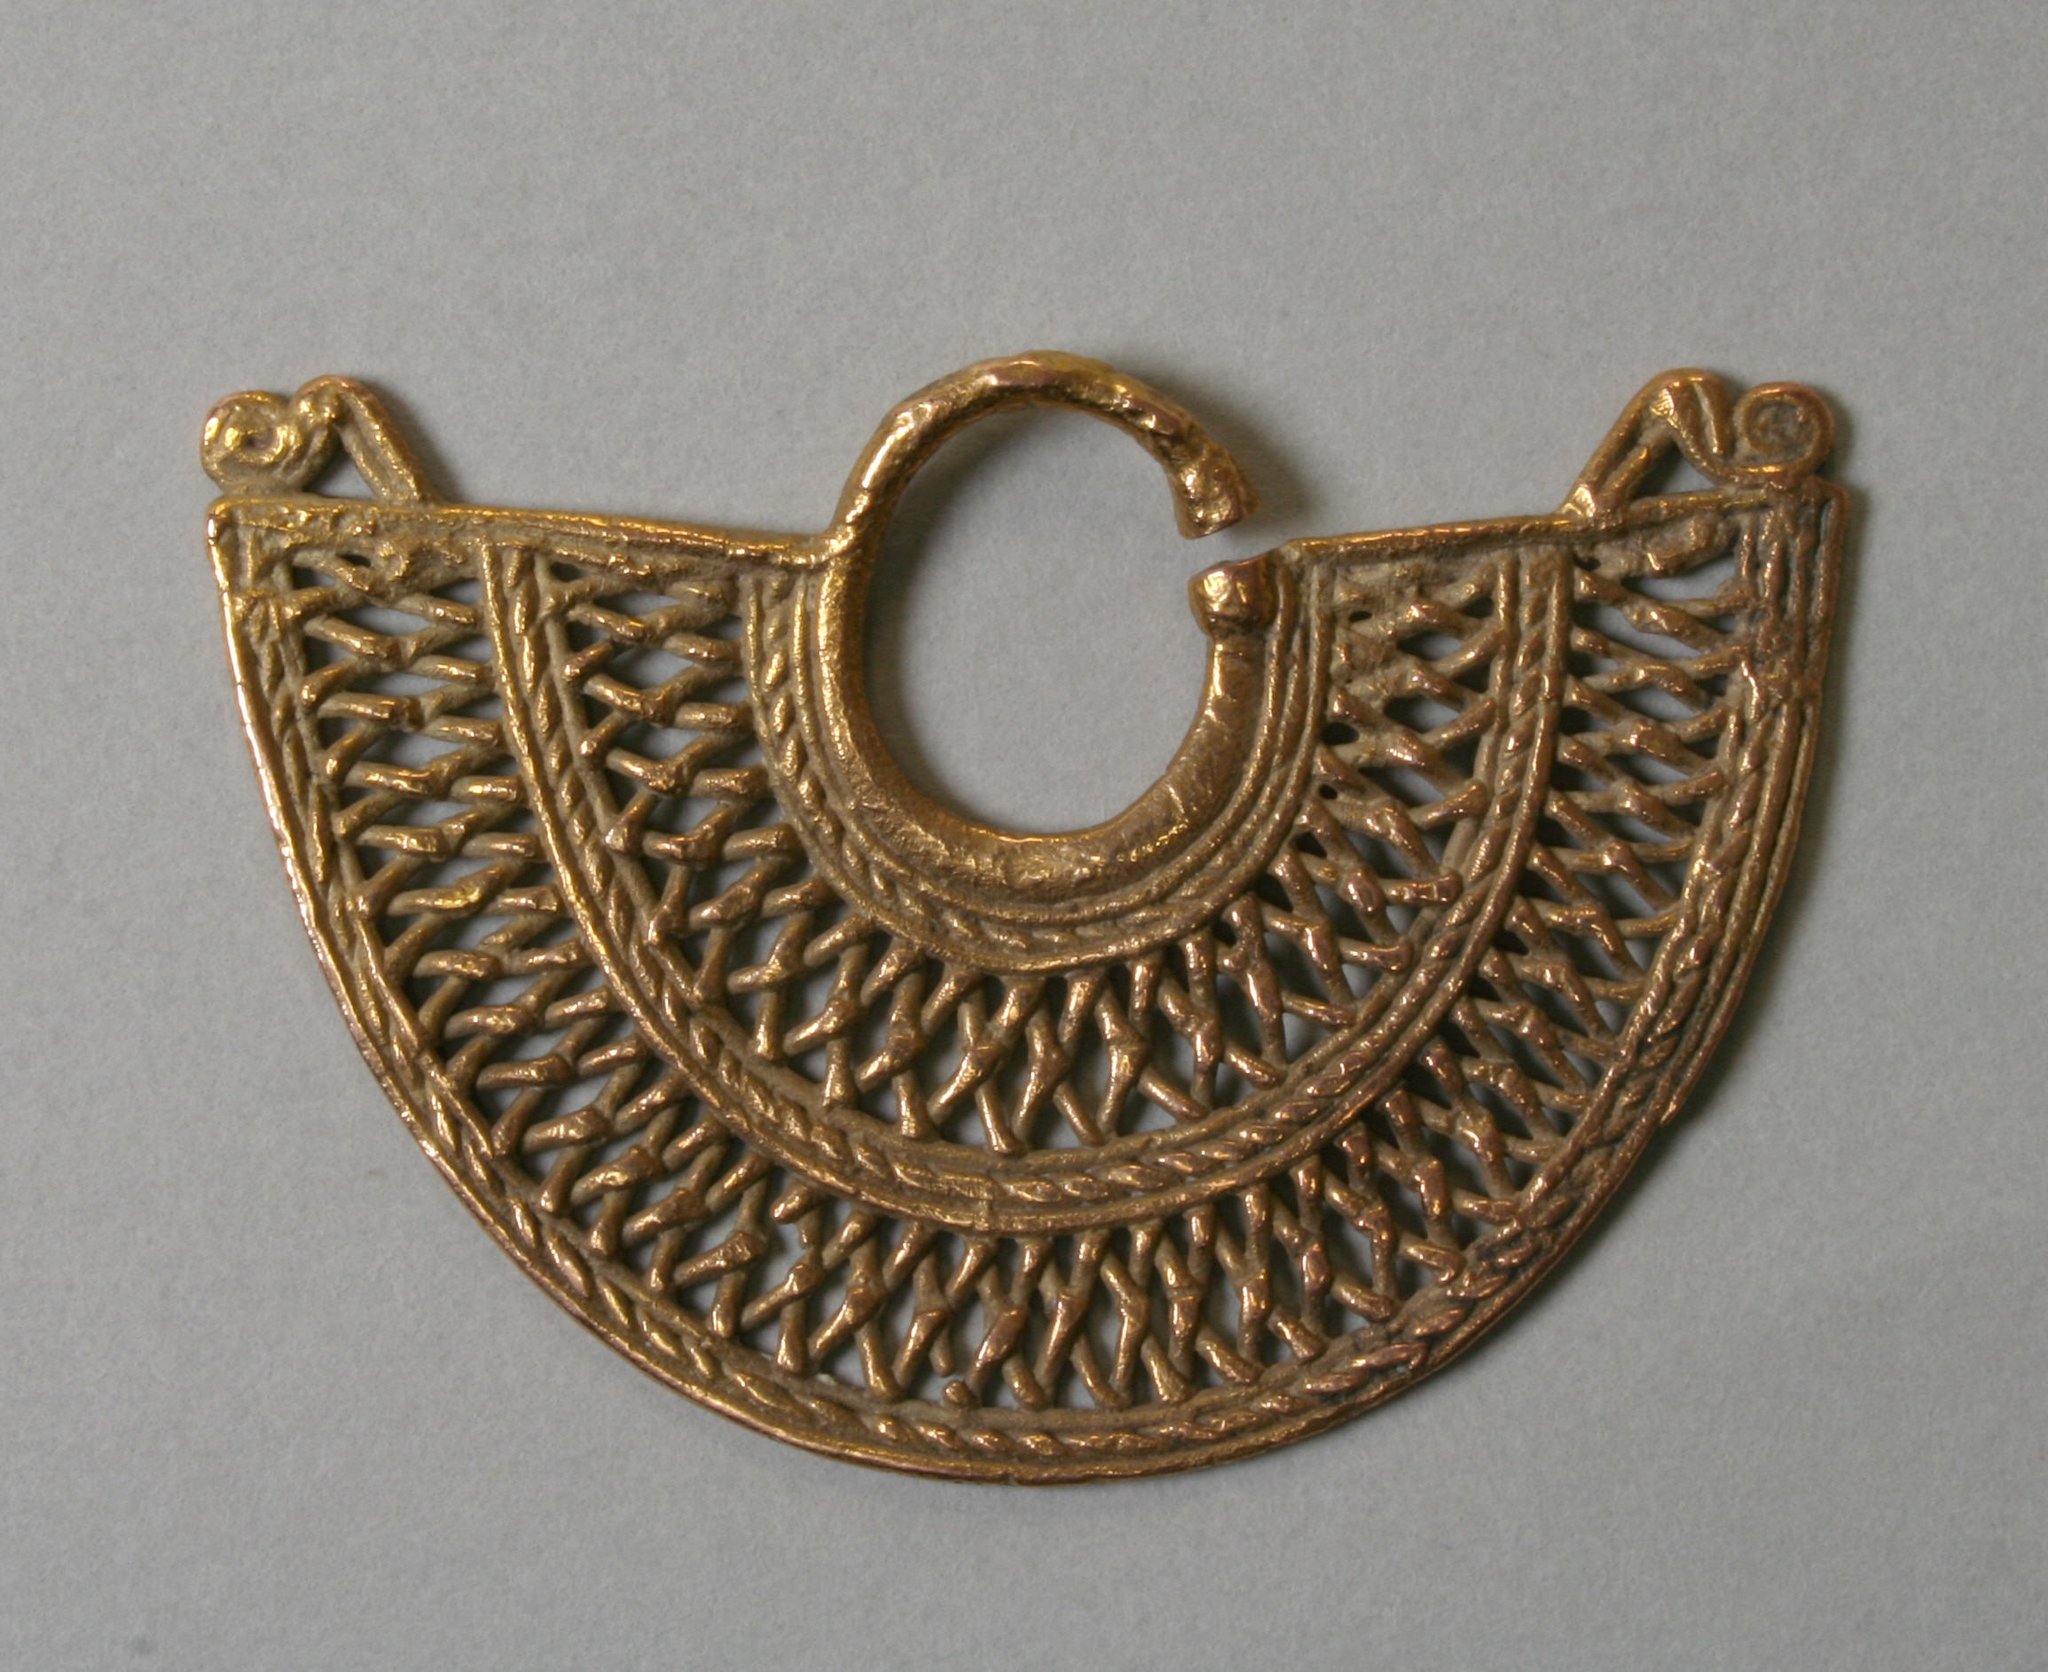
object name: ornament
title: Ear Ornament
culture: zenú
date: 1-1000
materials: gold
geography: colombia